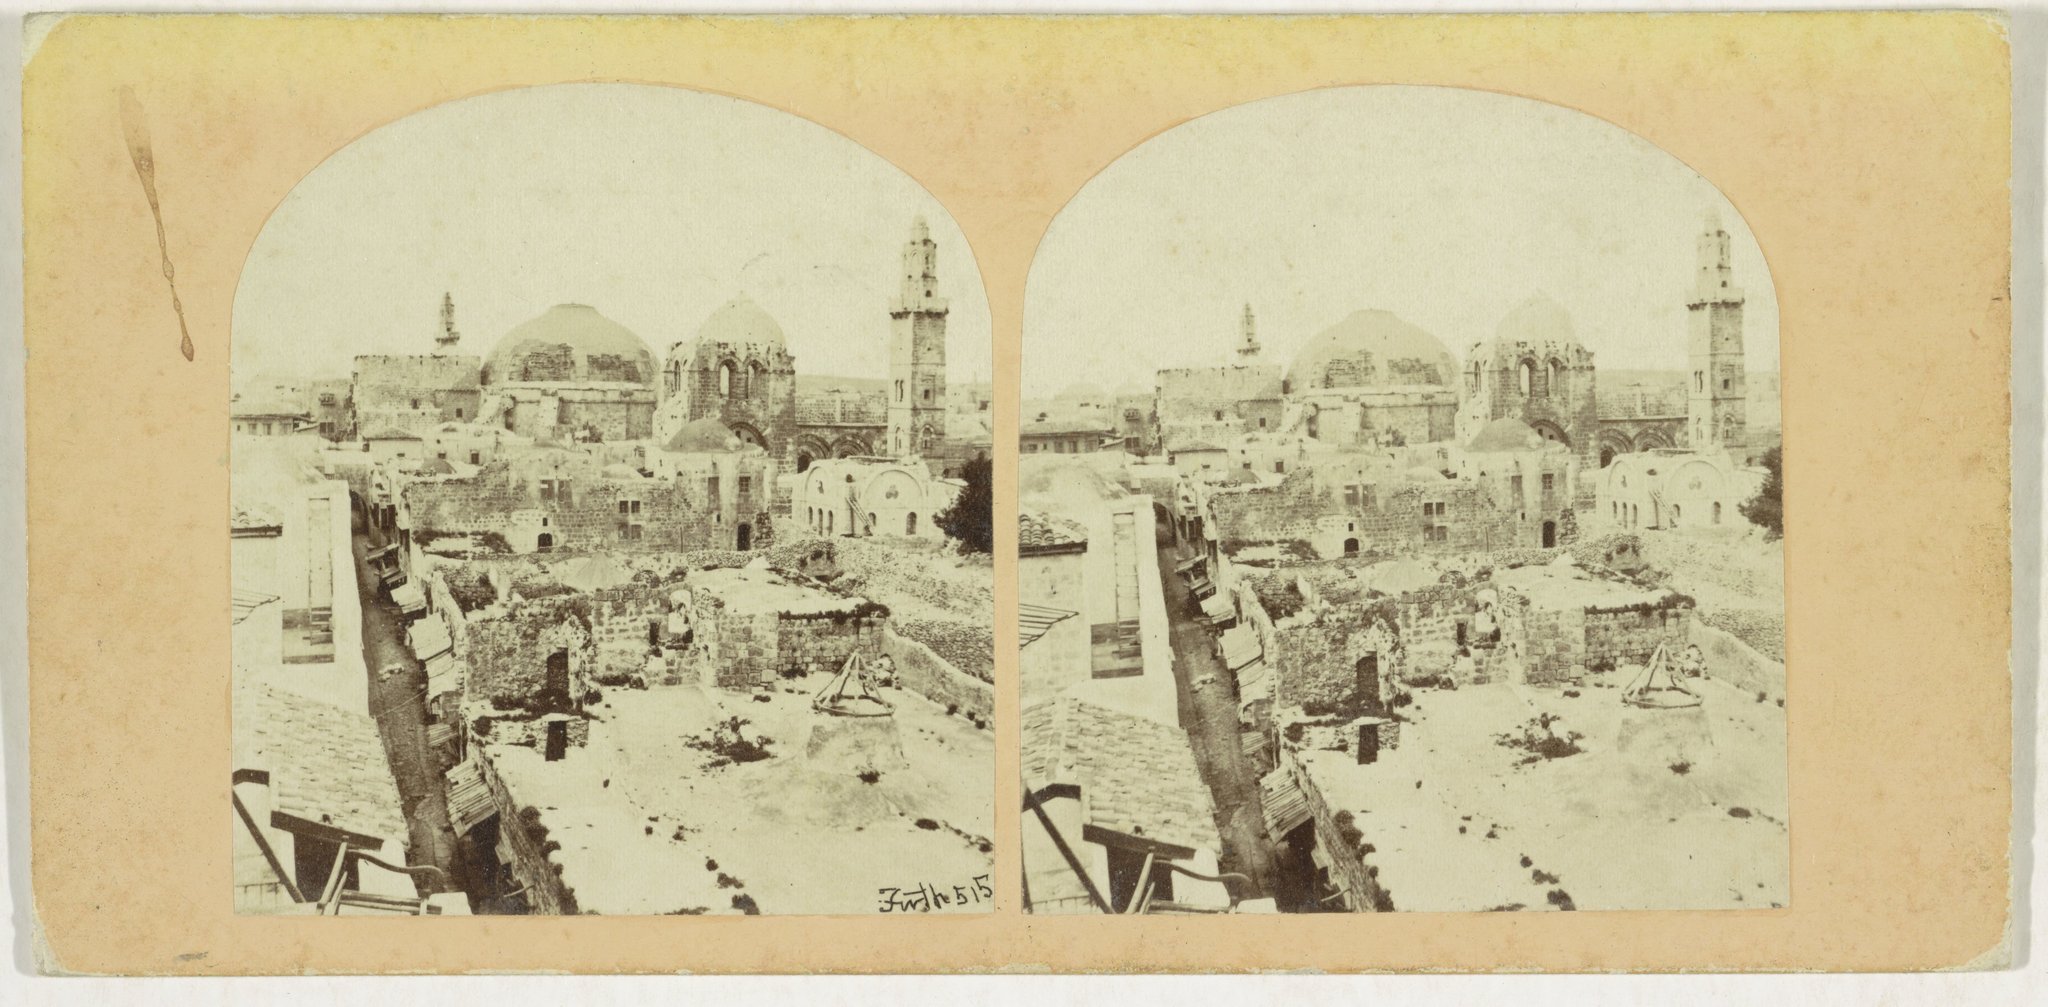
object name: stereograph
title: Street in Jerusalem, with Church of the Holy Sepulchre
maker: francis frith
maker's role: publisher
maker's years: 1822-1898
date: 1859-1861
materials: cardboard, paper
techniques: albumen print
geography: heilig grafkerk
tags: parts of church exterior and annexes: dome, roman catholic church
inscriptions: number: ‘515’, inscription: ‘NOTWITHSTANDING the natural advantages of its situation, modern Jerusalem is certainly one of the poorest and dirtiest/ cities (considering the amount of its population) in (...)’, inscription: ‘Entered at Stationers' Hall.]’, inscription: ‘[Deposé.’, inscription: ‘Rue de Jerusalem avec l'eglise du St Sepulcre.’